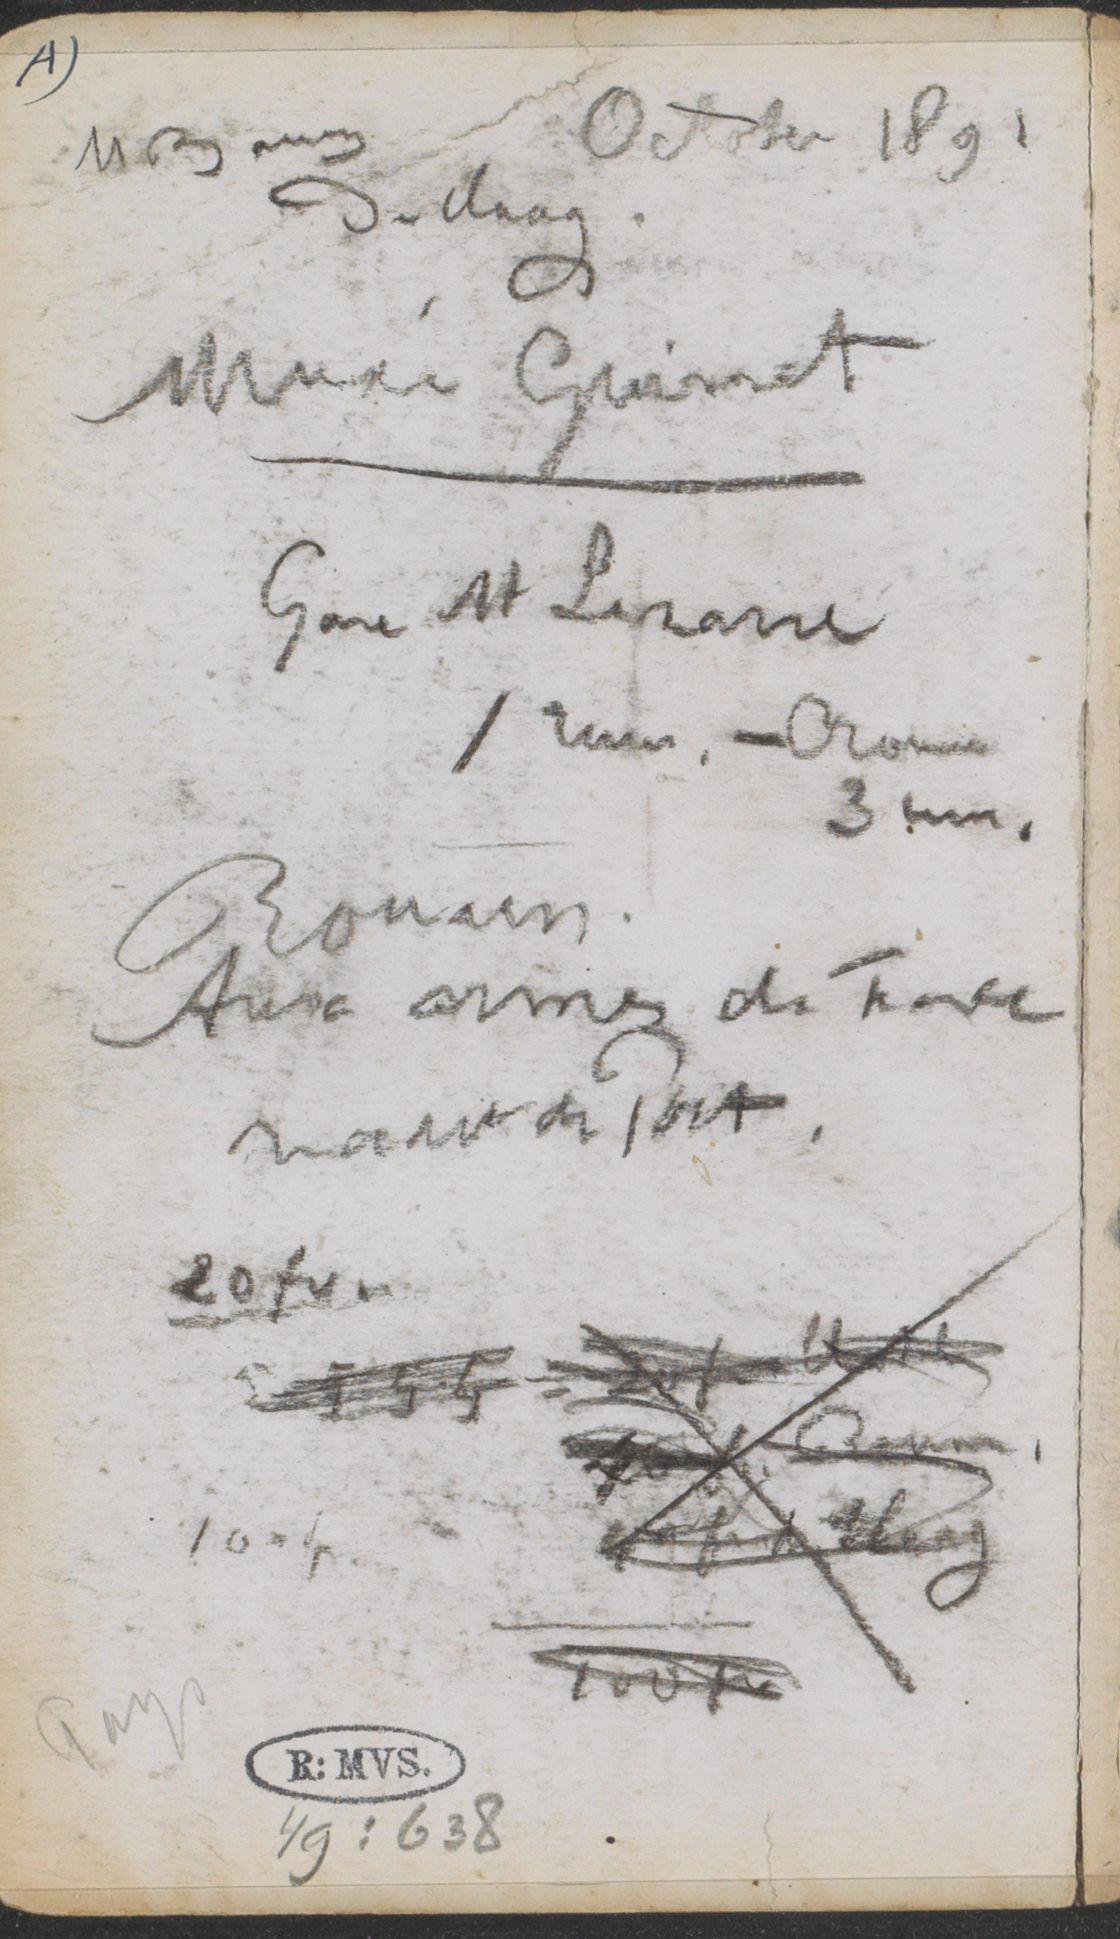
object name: endleaf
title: Blad met notities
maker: marius bauer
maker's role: draughtsman, print maker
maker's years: 1867-1932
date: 1810-1891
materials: chalk, paper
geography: the hague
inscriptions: annotation: ‘MBauer October 1891/ D. Haag./ Musée Guimet/ Gare St Lazare [...]’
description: Voorste schutblad uit een schetsboek met 35 bladen.